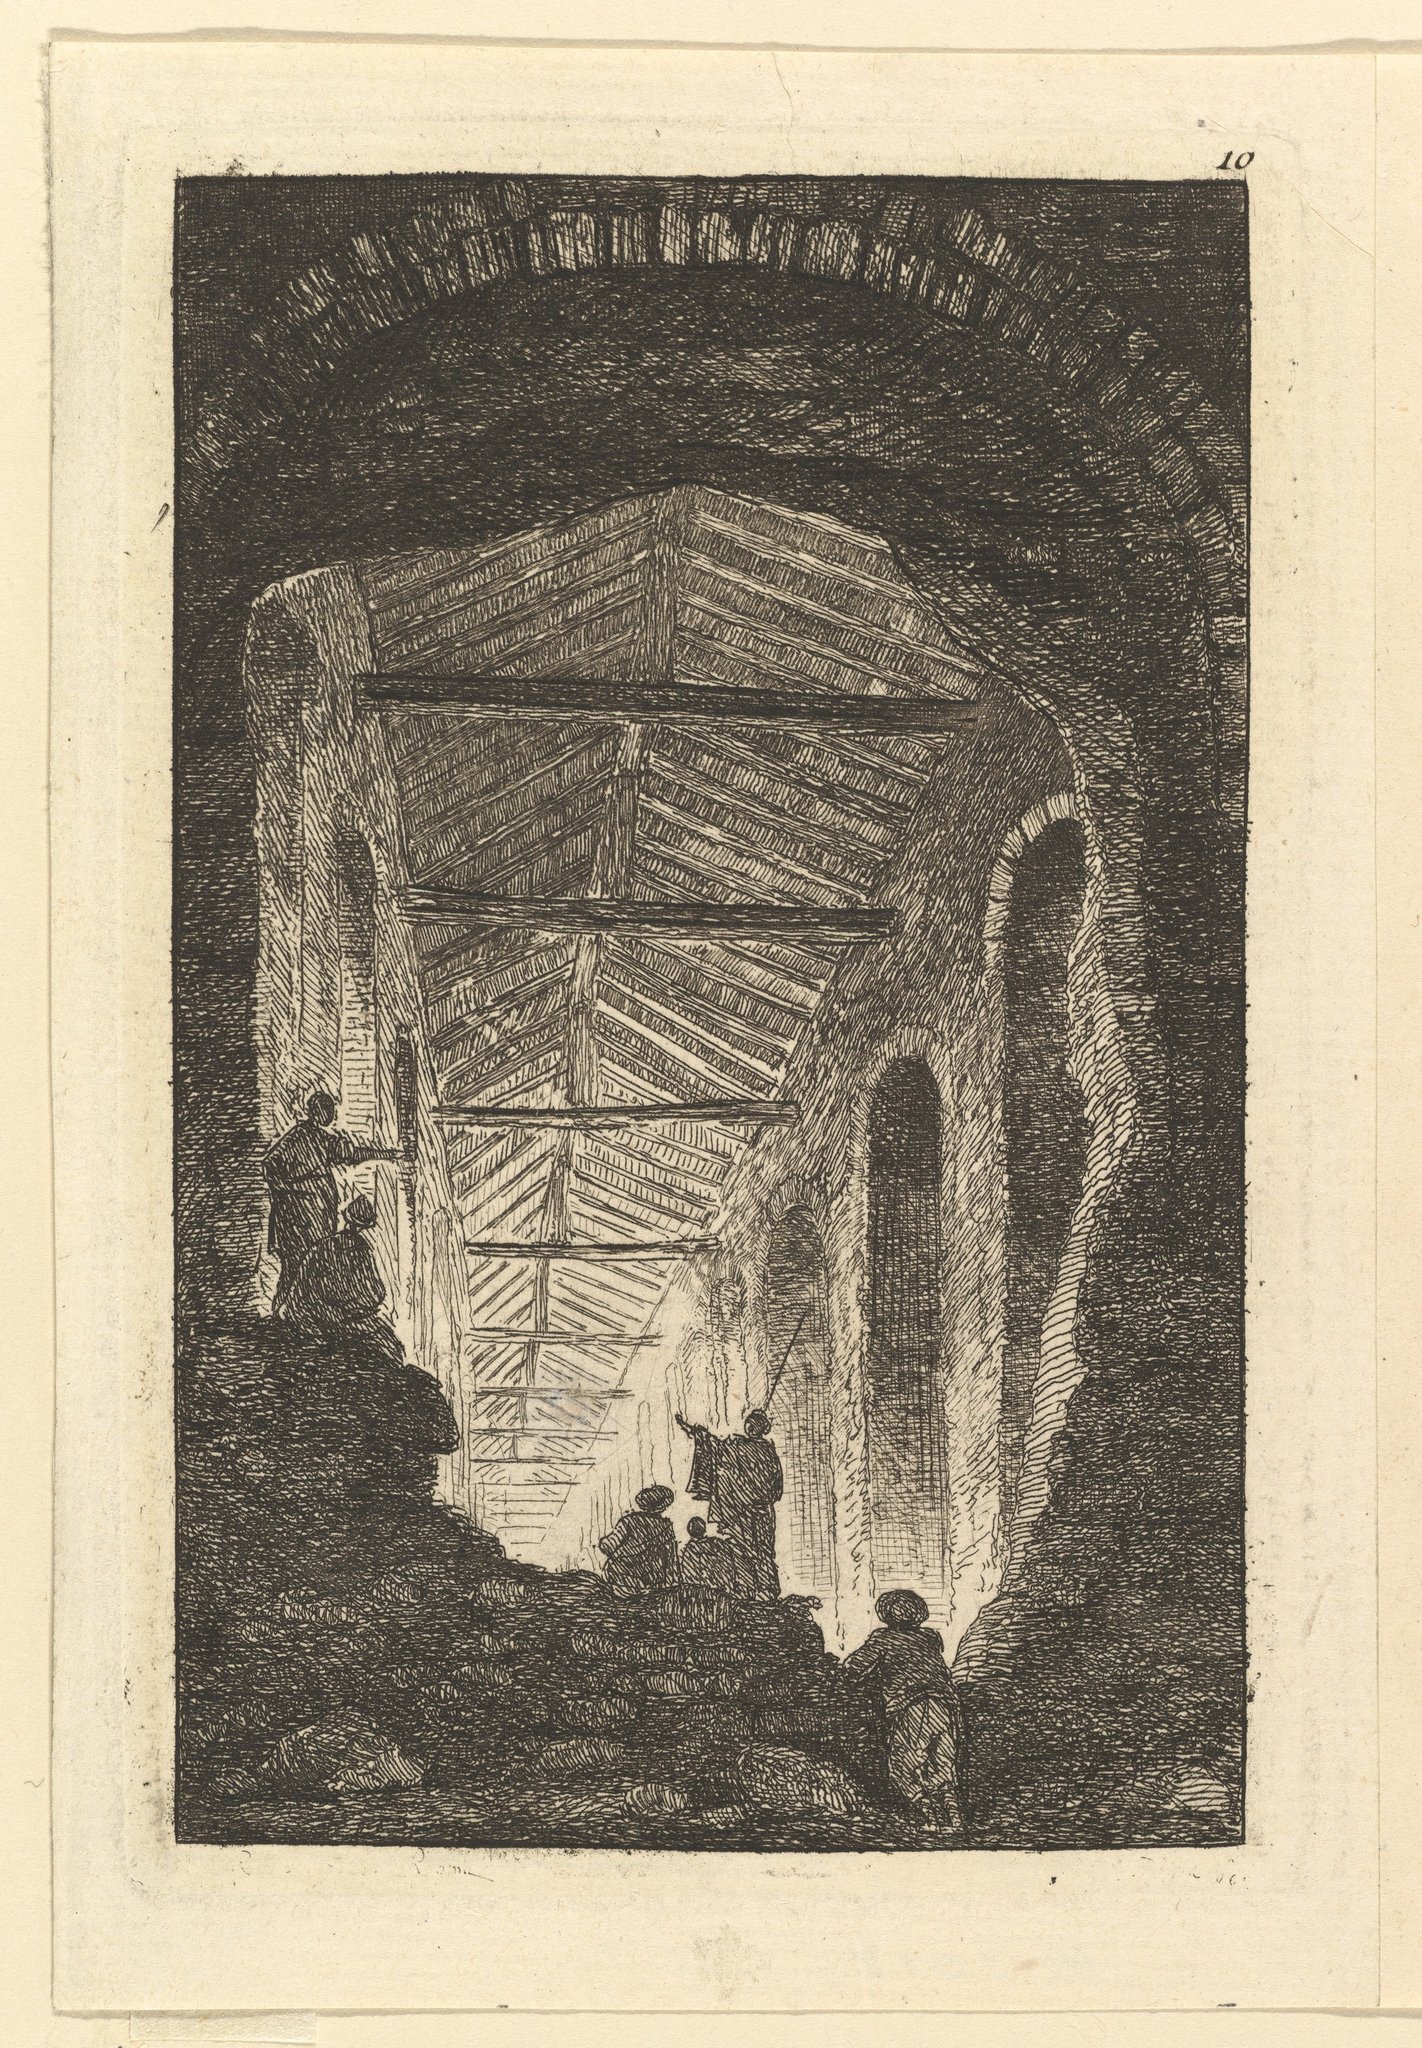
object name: print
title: La Galerie Antique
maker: hubert robert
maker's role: artist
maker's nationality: french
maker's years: 1733-1808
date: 1763-1765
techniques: etching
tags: buildings